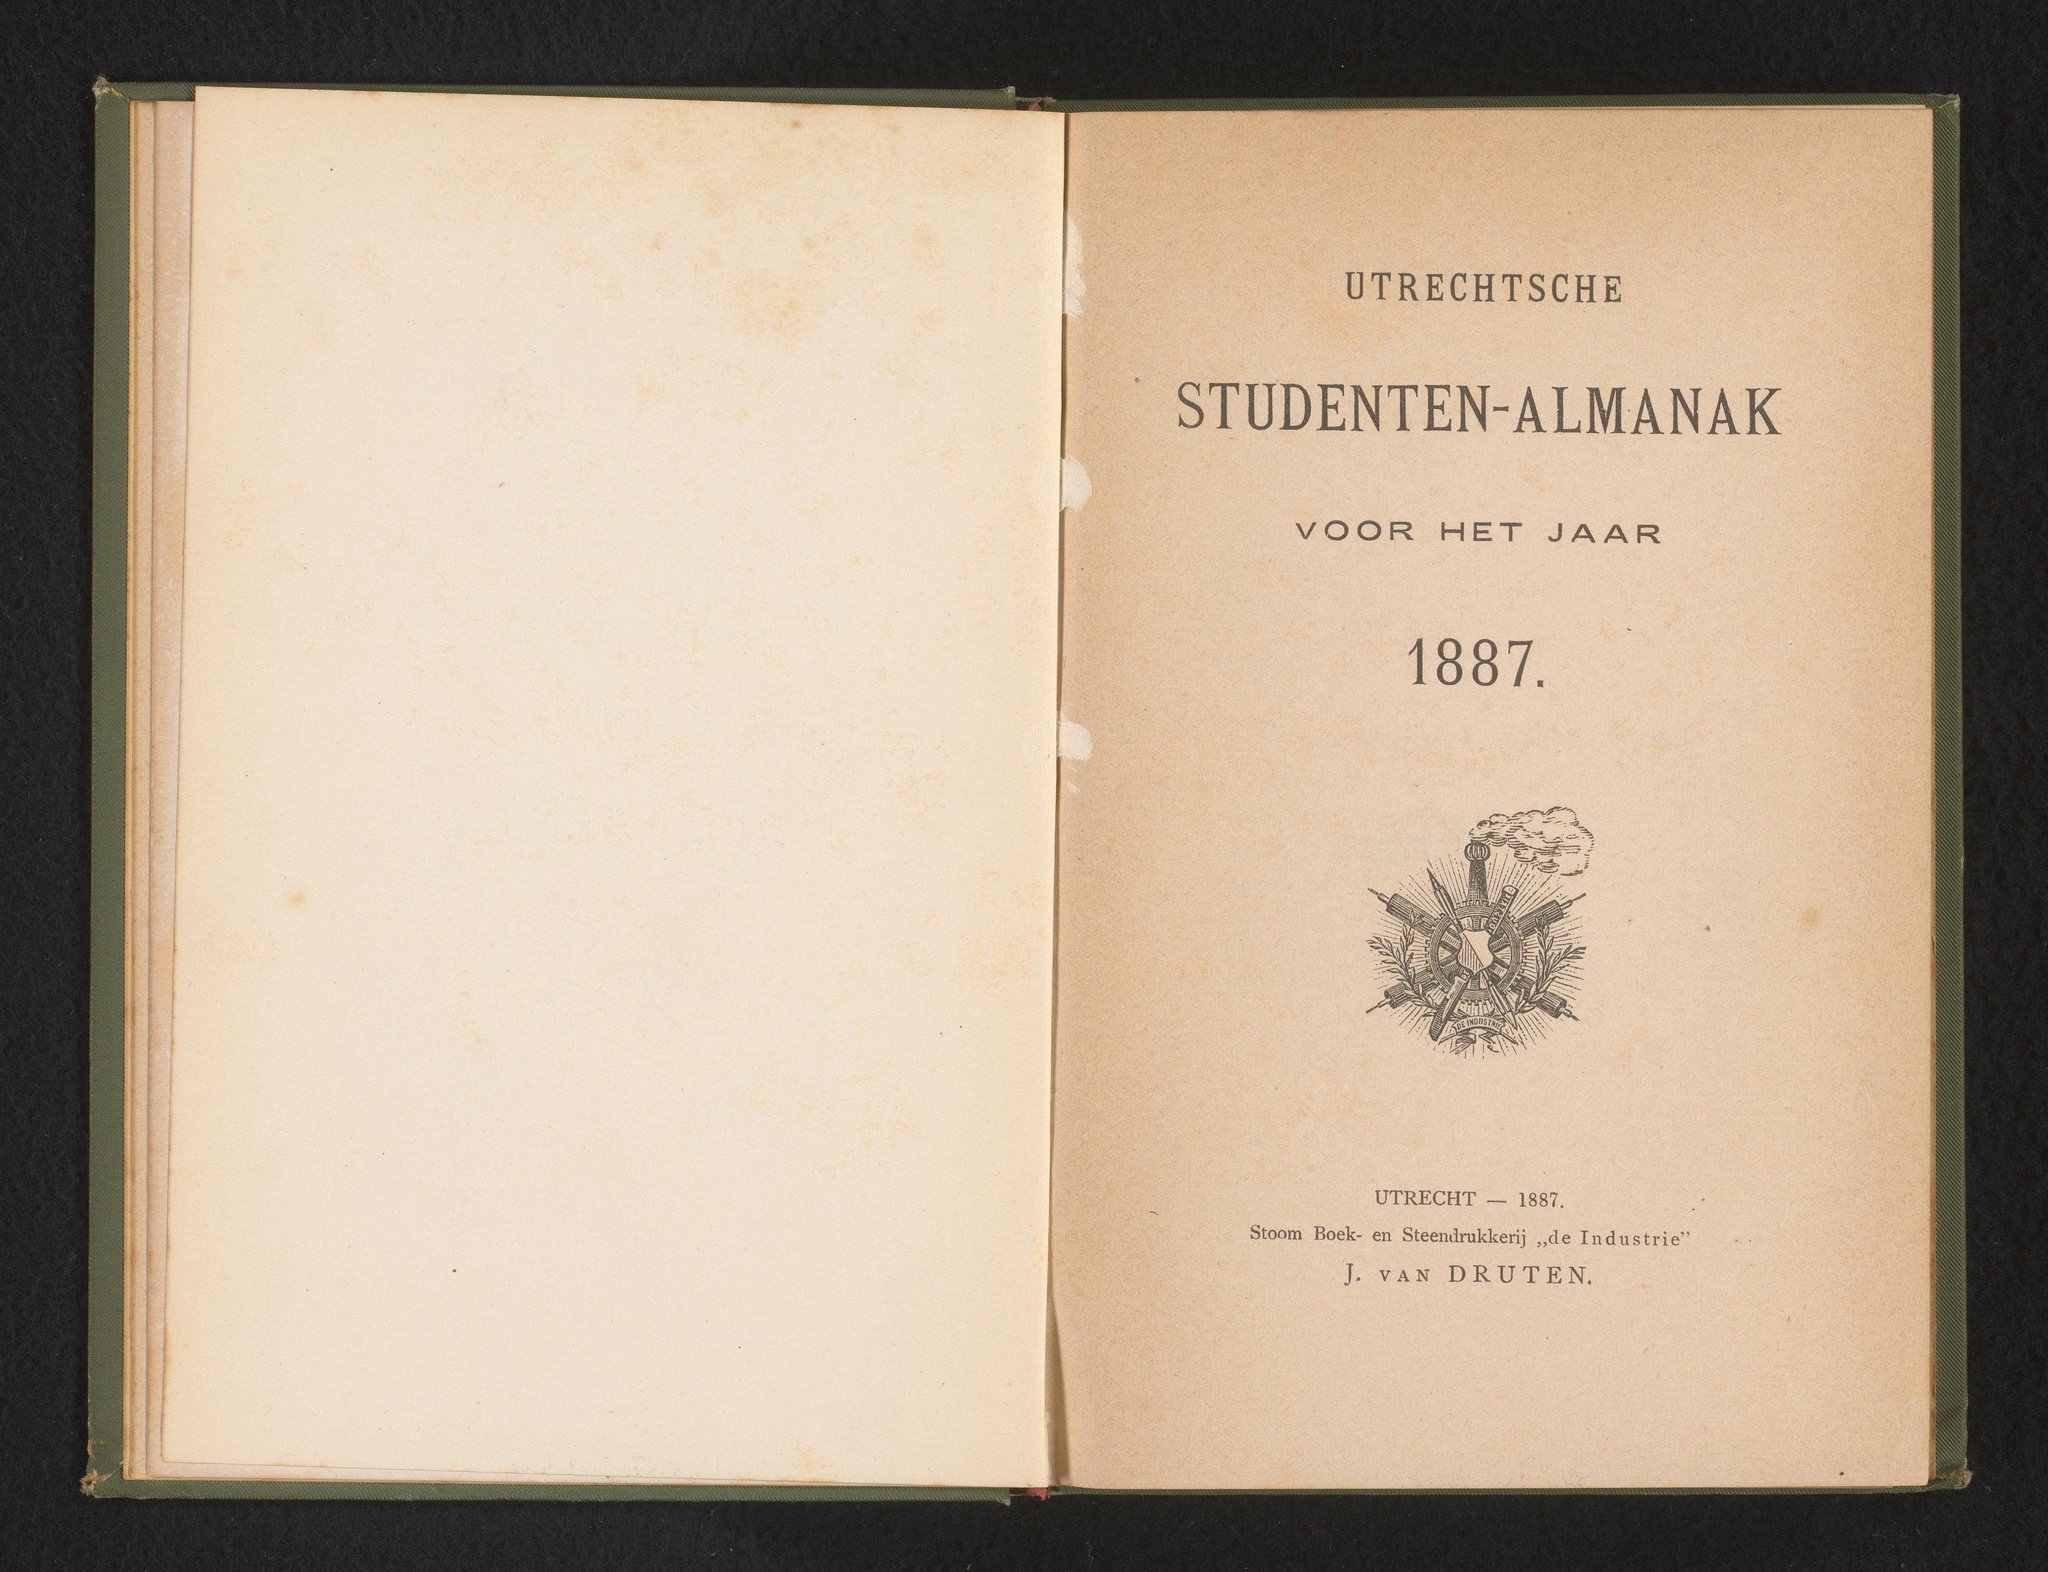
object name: book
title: Utrechtsche studenten-almanak voor het jaar 1887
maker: j. van druten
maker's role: publisher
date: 1887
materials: paper, cardboard, linen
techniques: photograph, letterpress printing, lithograph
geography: utrecht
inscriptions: number: ‘450’